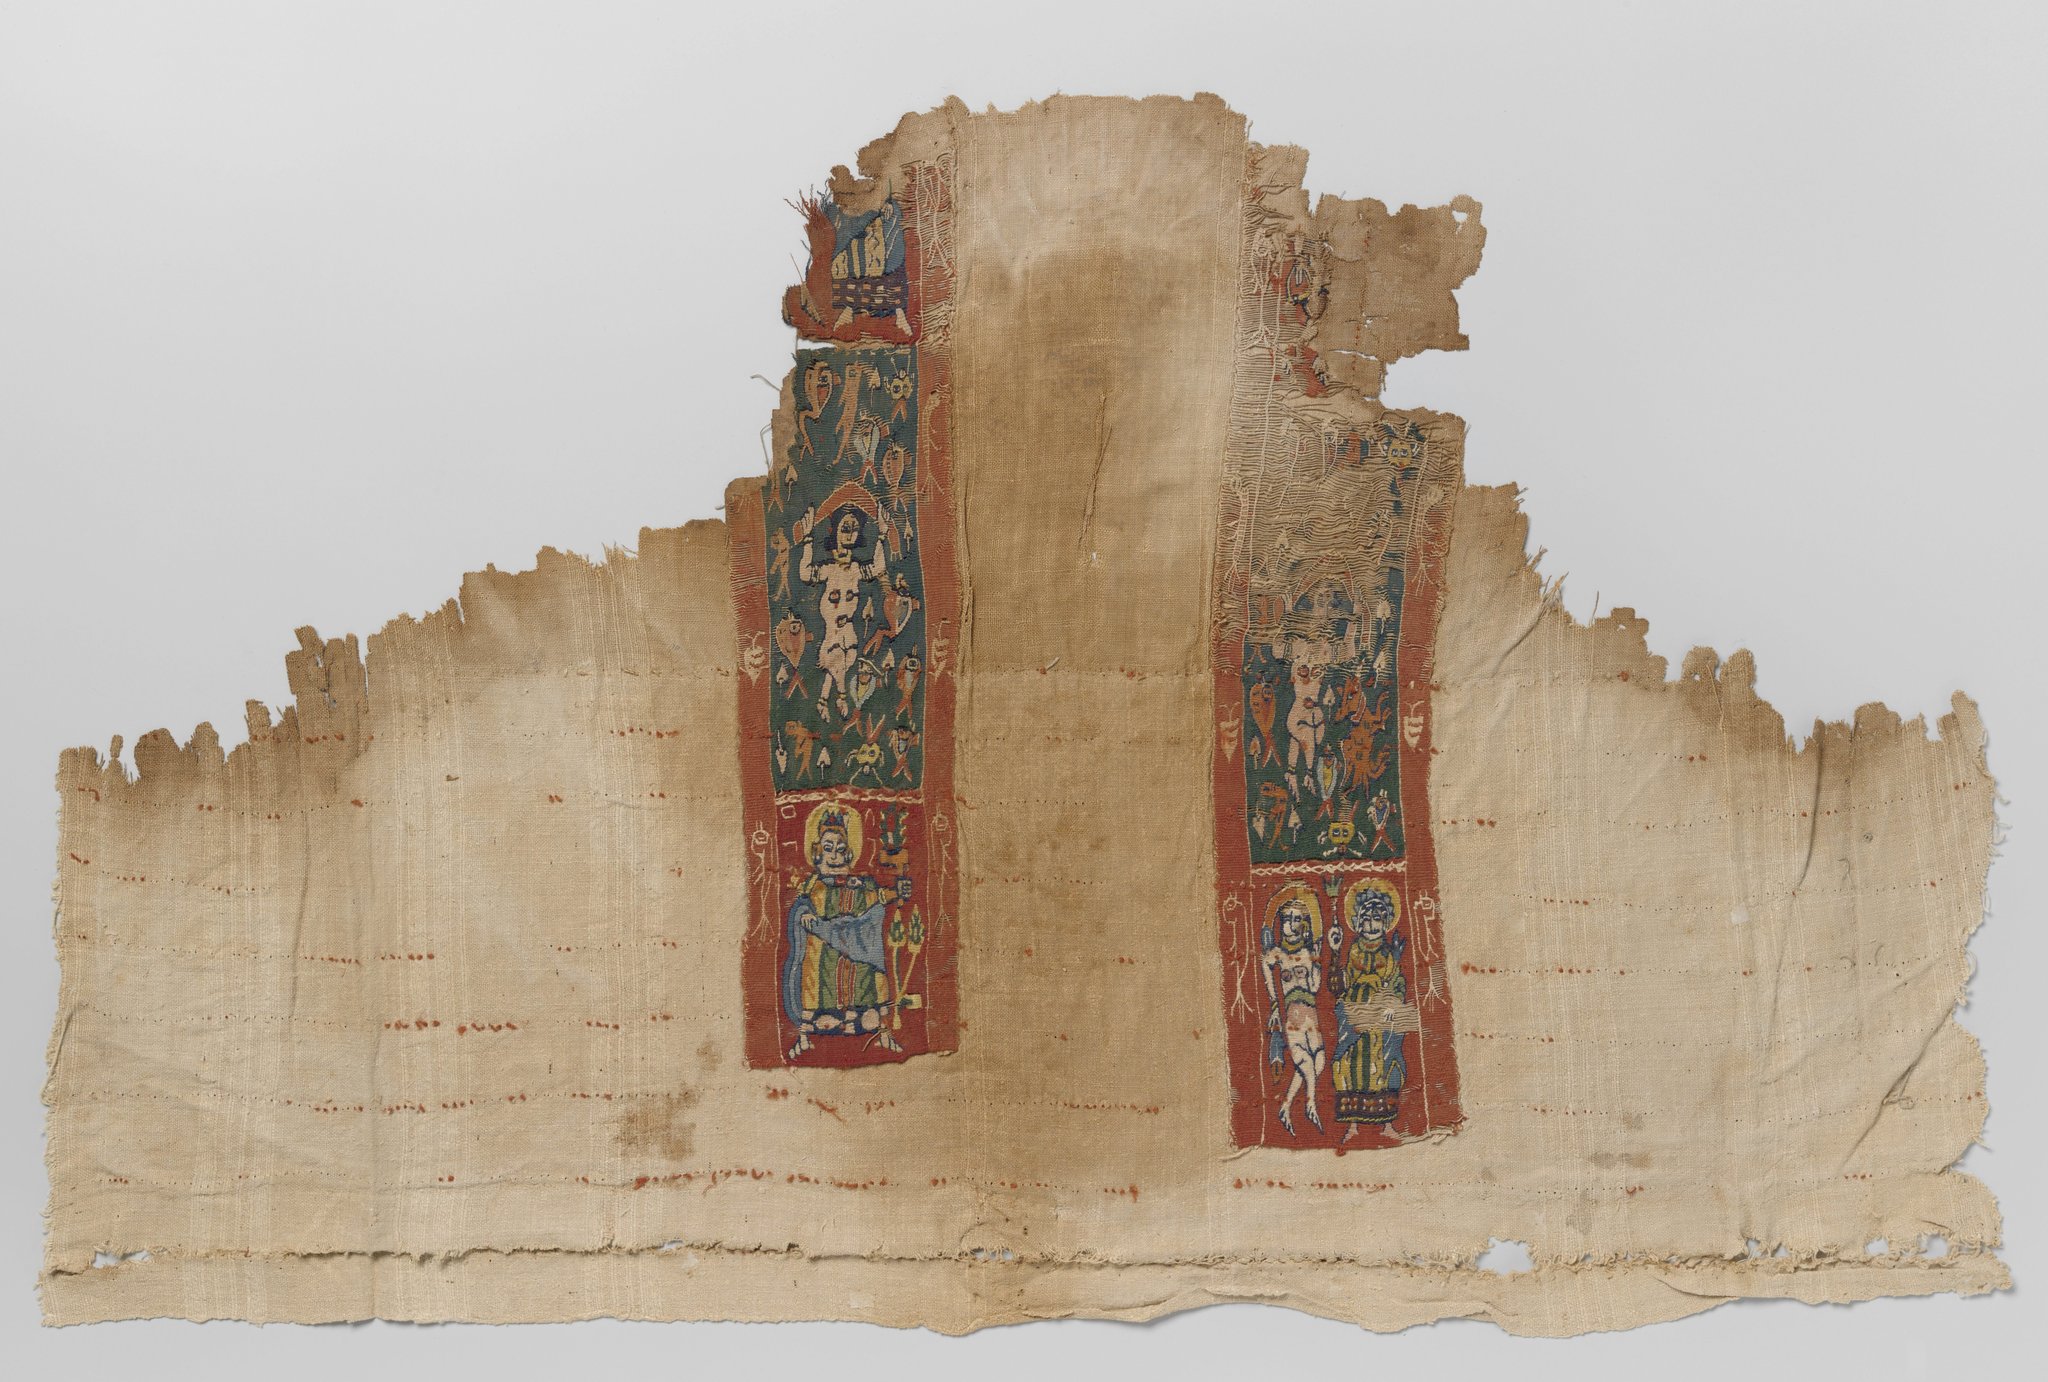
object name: tunicle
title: Fragment van een tunica met twee clavi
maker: Anonymous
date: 500-799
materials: linen, wool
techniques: embroidered, weave, tapestry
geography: egypt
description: Naturelkleurig linnen fragment van een tunica met twee opgenaaide clavi. De clavi zijn in vakken verdeeld. Op de linker clavus zien we op een rode grond een heilige met een nimbus met een gewaad in lichtblauw, donkerblauw, lichtgroen, donkergroen, geel, oranje en rood. Daarboven op een donkergroene grond een naakte dansende vrouw met de armen in de lucht en een doek in de handen, omgeven door vissen in rood, oranje, roze, lichtblauw en geel. Daarboven een fragment van een figuur in een gewaad in blauw, geel, paars en oranje op rode grond. De rechter clavus toont in het onderste vak een heilige met nimbus in een lang gewaad in lichtblauw, donkerblauw, lichtgroen, donkergroen, geel en paars. Daarnaast staat een dansende naakte vrouw met een doek in de handen in geel, oranje en blauw. Het vak hierboven is gelijk aan dat van de linker clavus, maar fragmentarischer. Van het derde vak bovenaan resten slechts fragmenten. Beide clavi hebben rode randen met een fijn vismotief. Het basisweefsel heeft op regelmatige afstanden dikkere ingeweven inslagen die strepen vormen. Dwars over het weefsel, op afstanden van ca. drie centimeter, zijn de restanten van een geborduurd lijnpatroon in rode wol te zien.